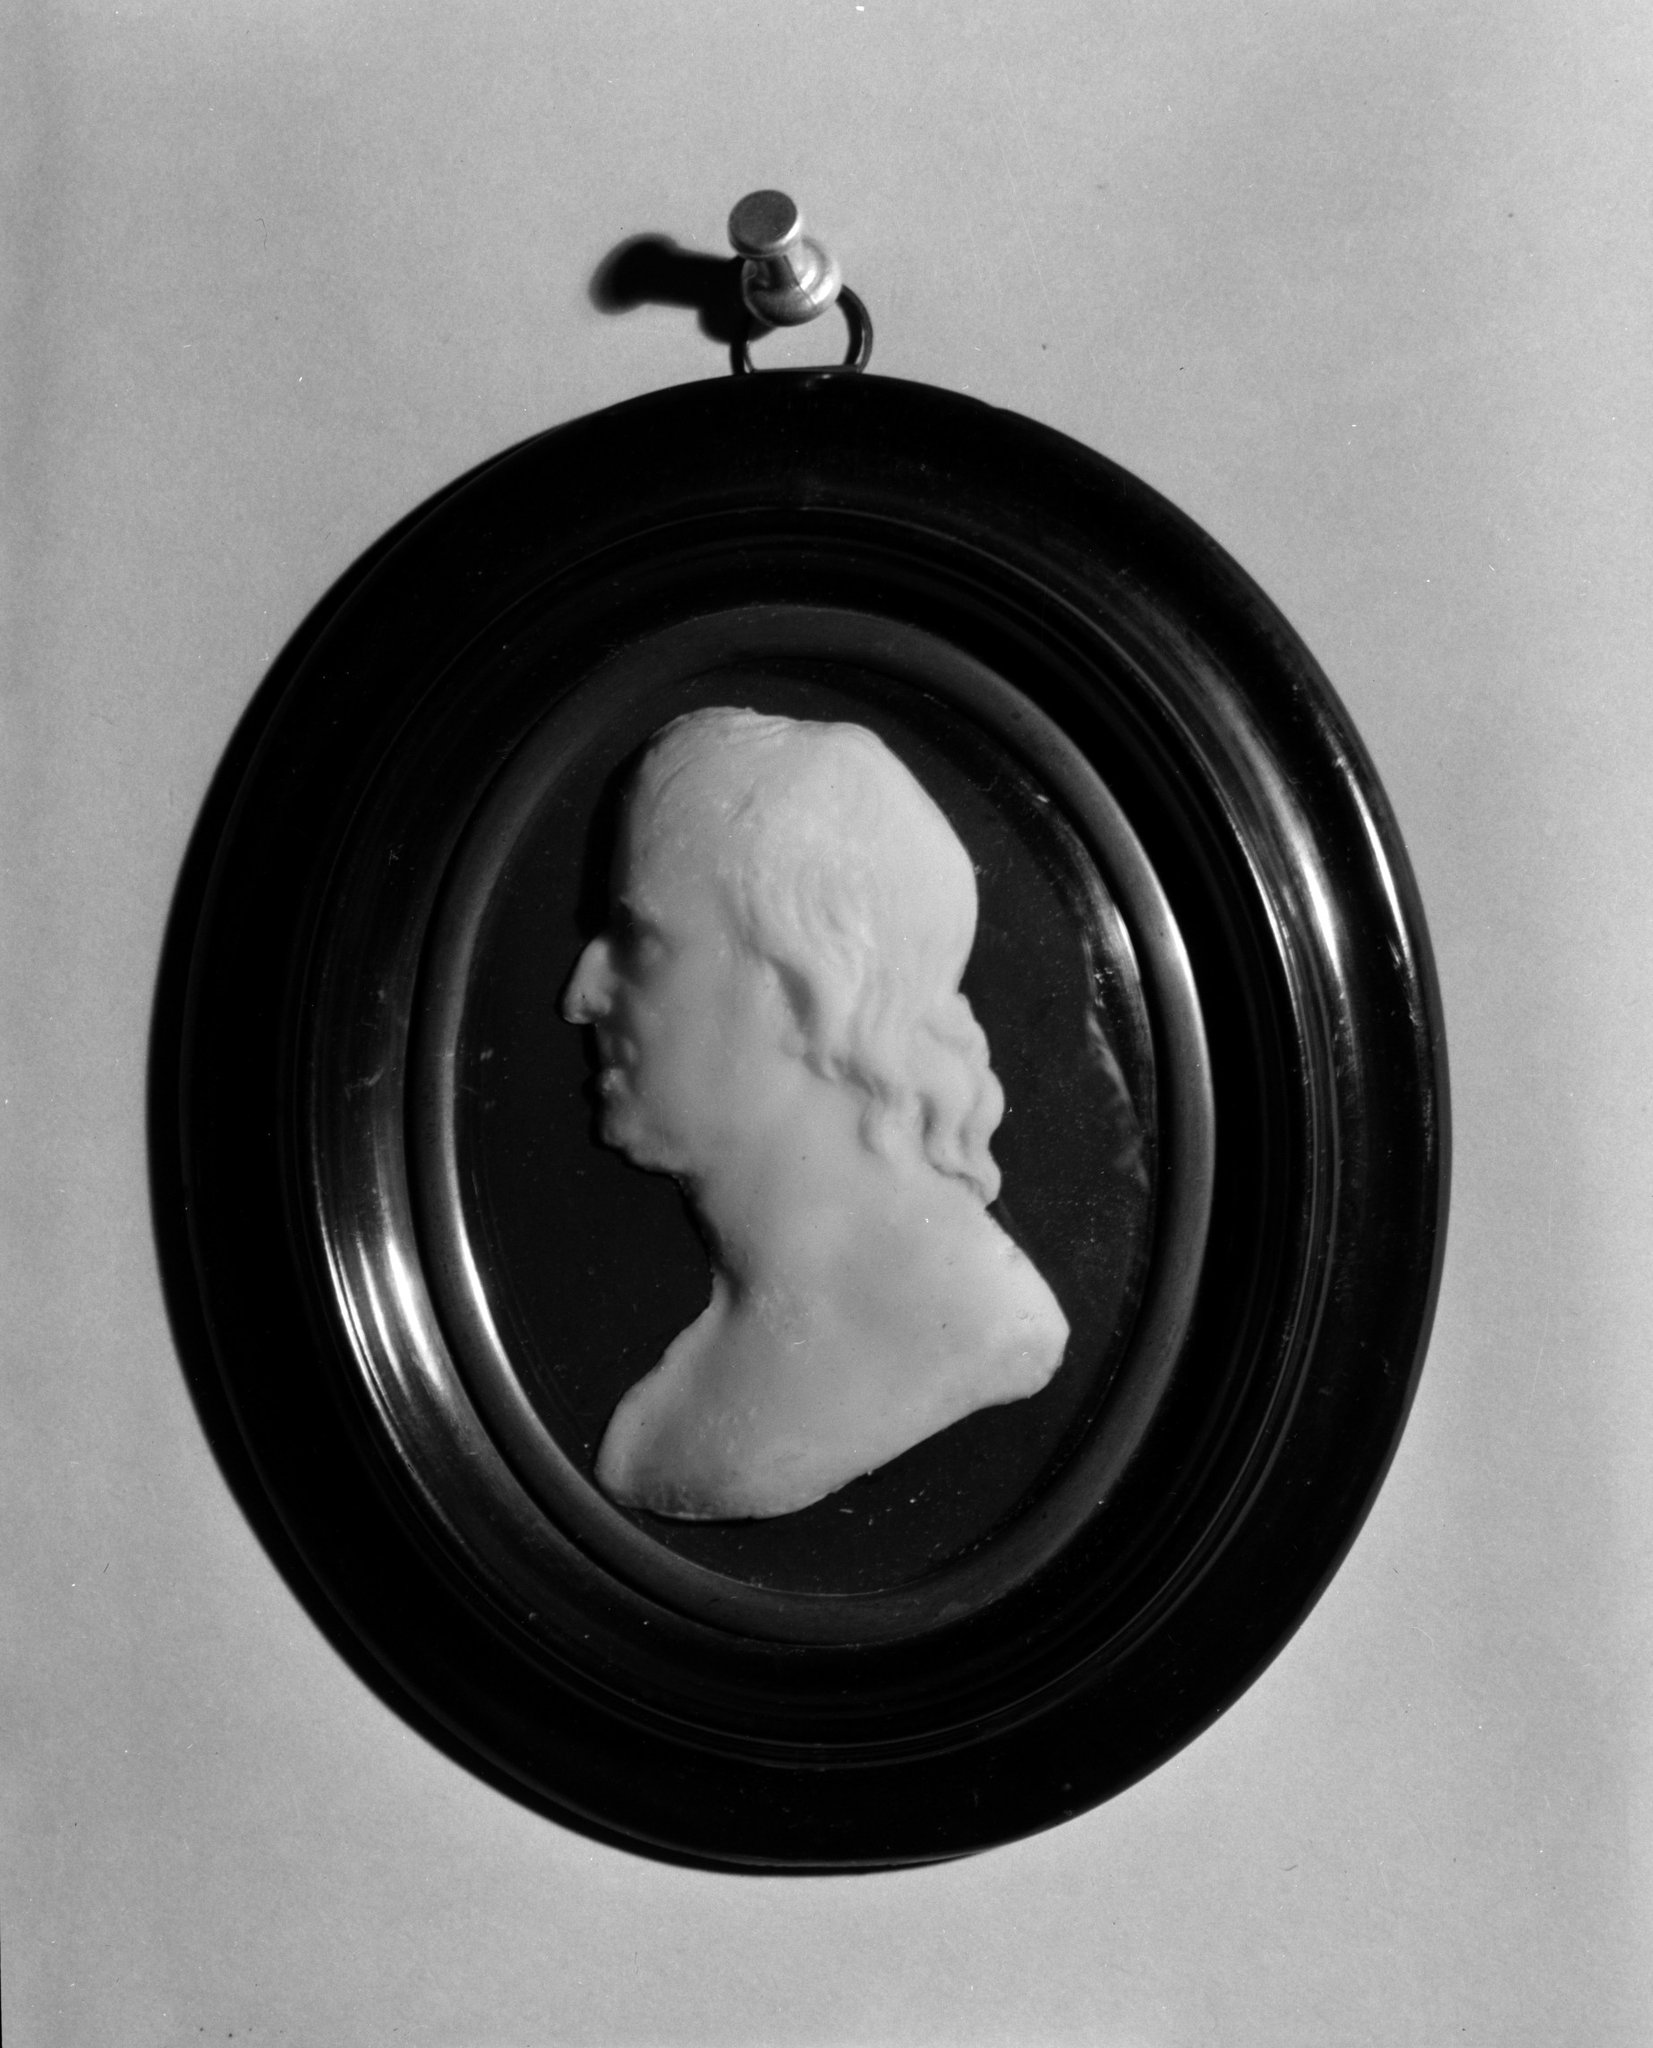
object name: bust, miniature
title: Profile Bust of George Washington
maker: robert ball hughes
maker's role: maker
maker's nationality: american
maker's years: 1806-1868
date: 1835-1855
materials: glass, wax, wood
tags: george washington,profiles